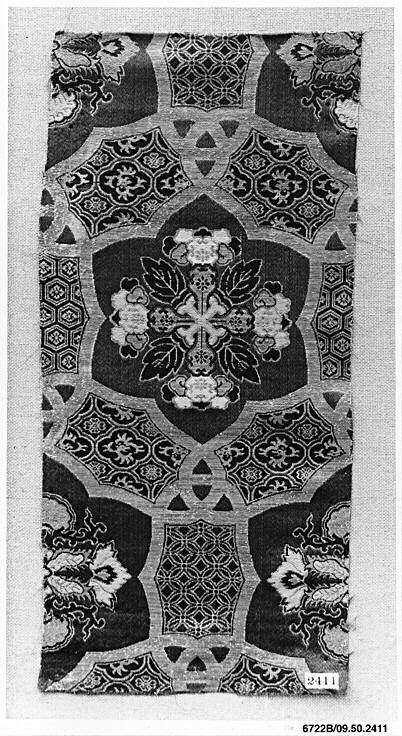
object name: piece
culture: japanese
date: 1615-1868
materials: silk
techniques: brocade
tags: leaves